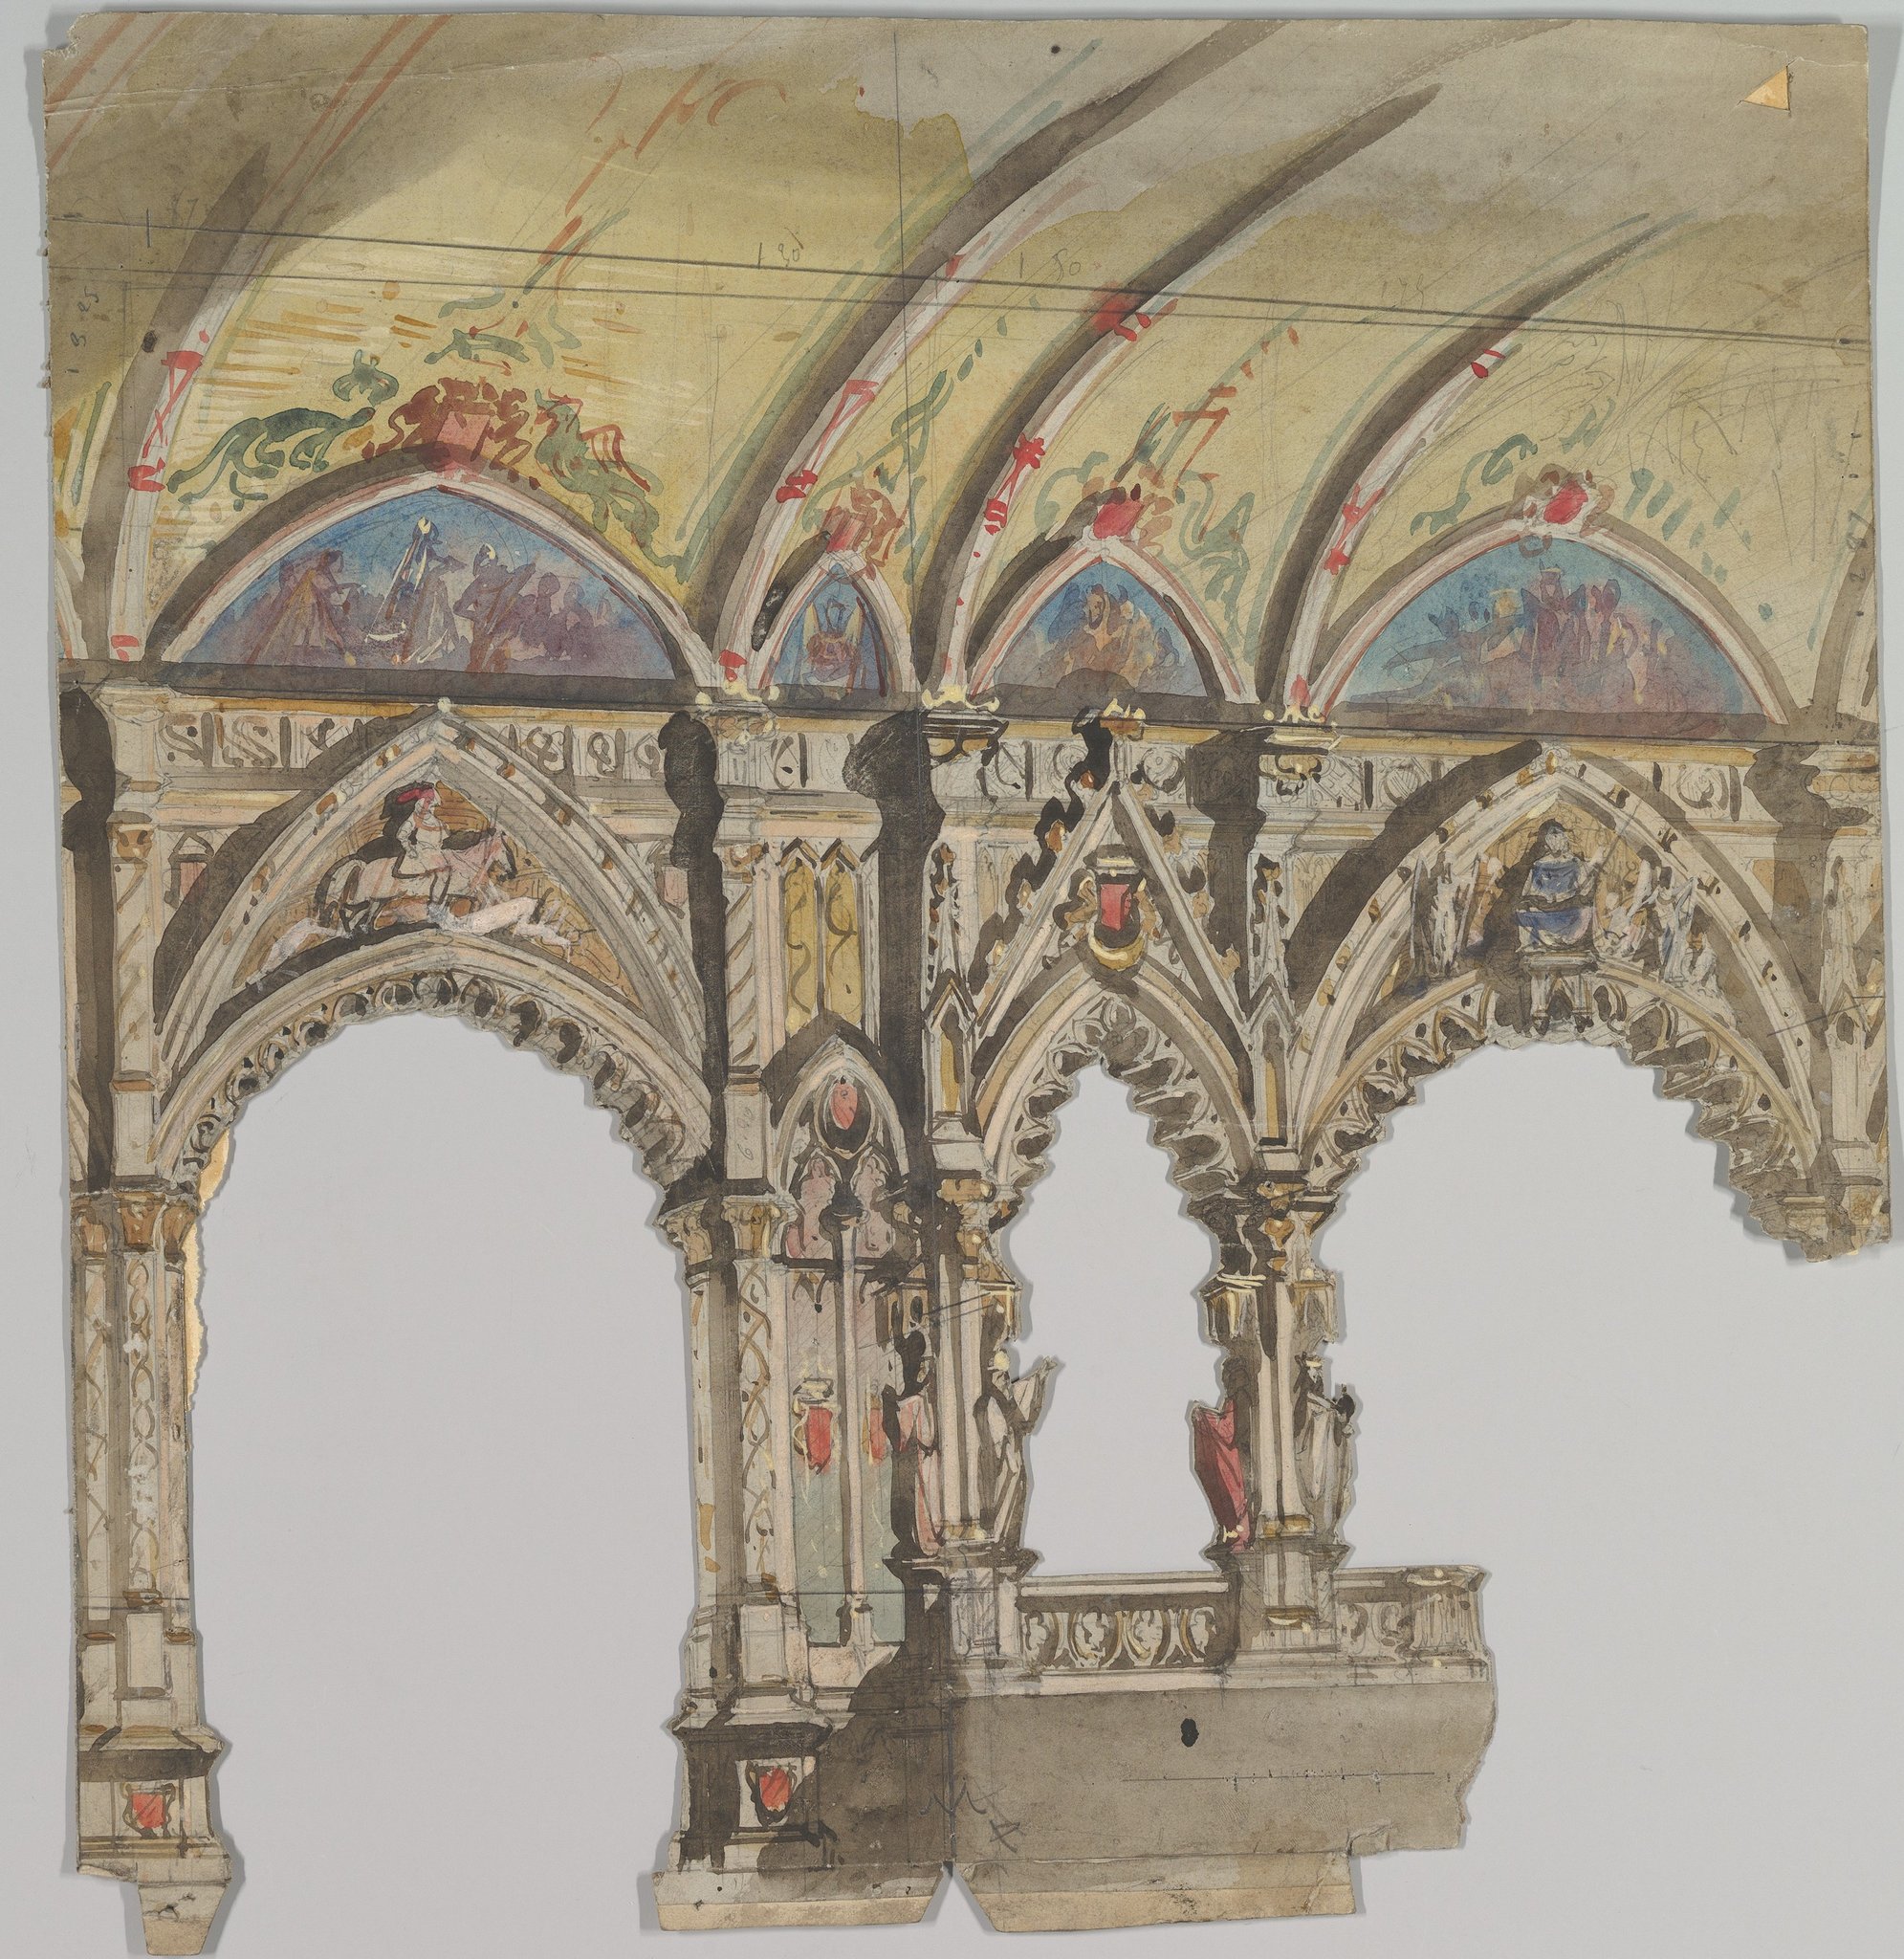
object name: drawing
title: Design for a Stage Set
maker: eugène cicéri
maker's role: artist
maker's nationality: french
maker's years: 1813-1890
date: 1830-1900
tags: arches,stage design